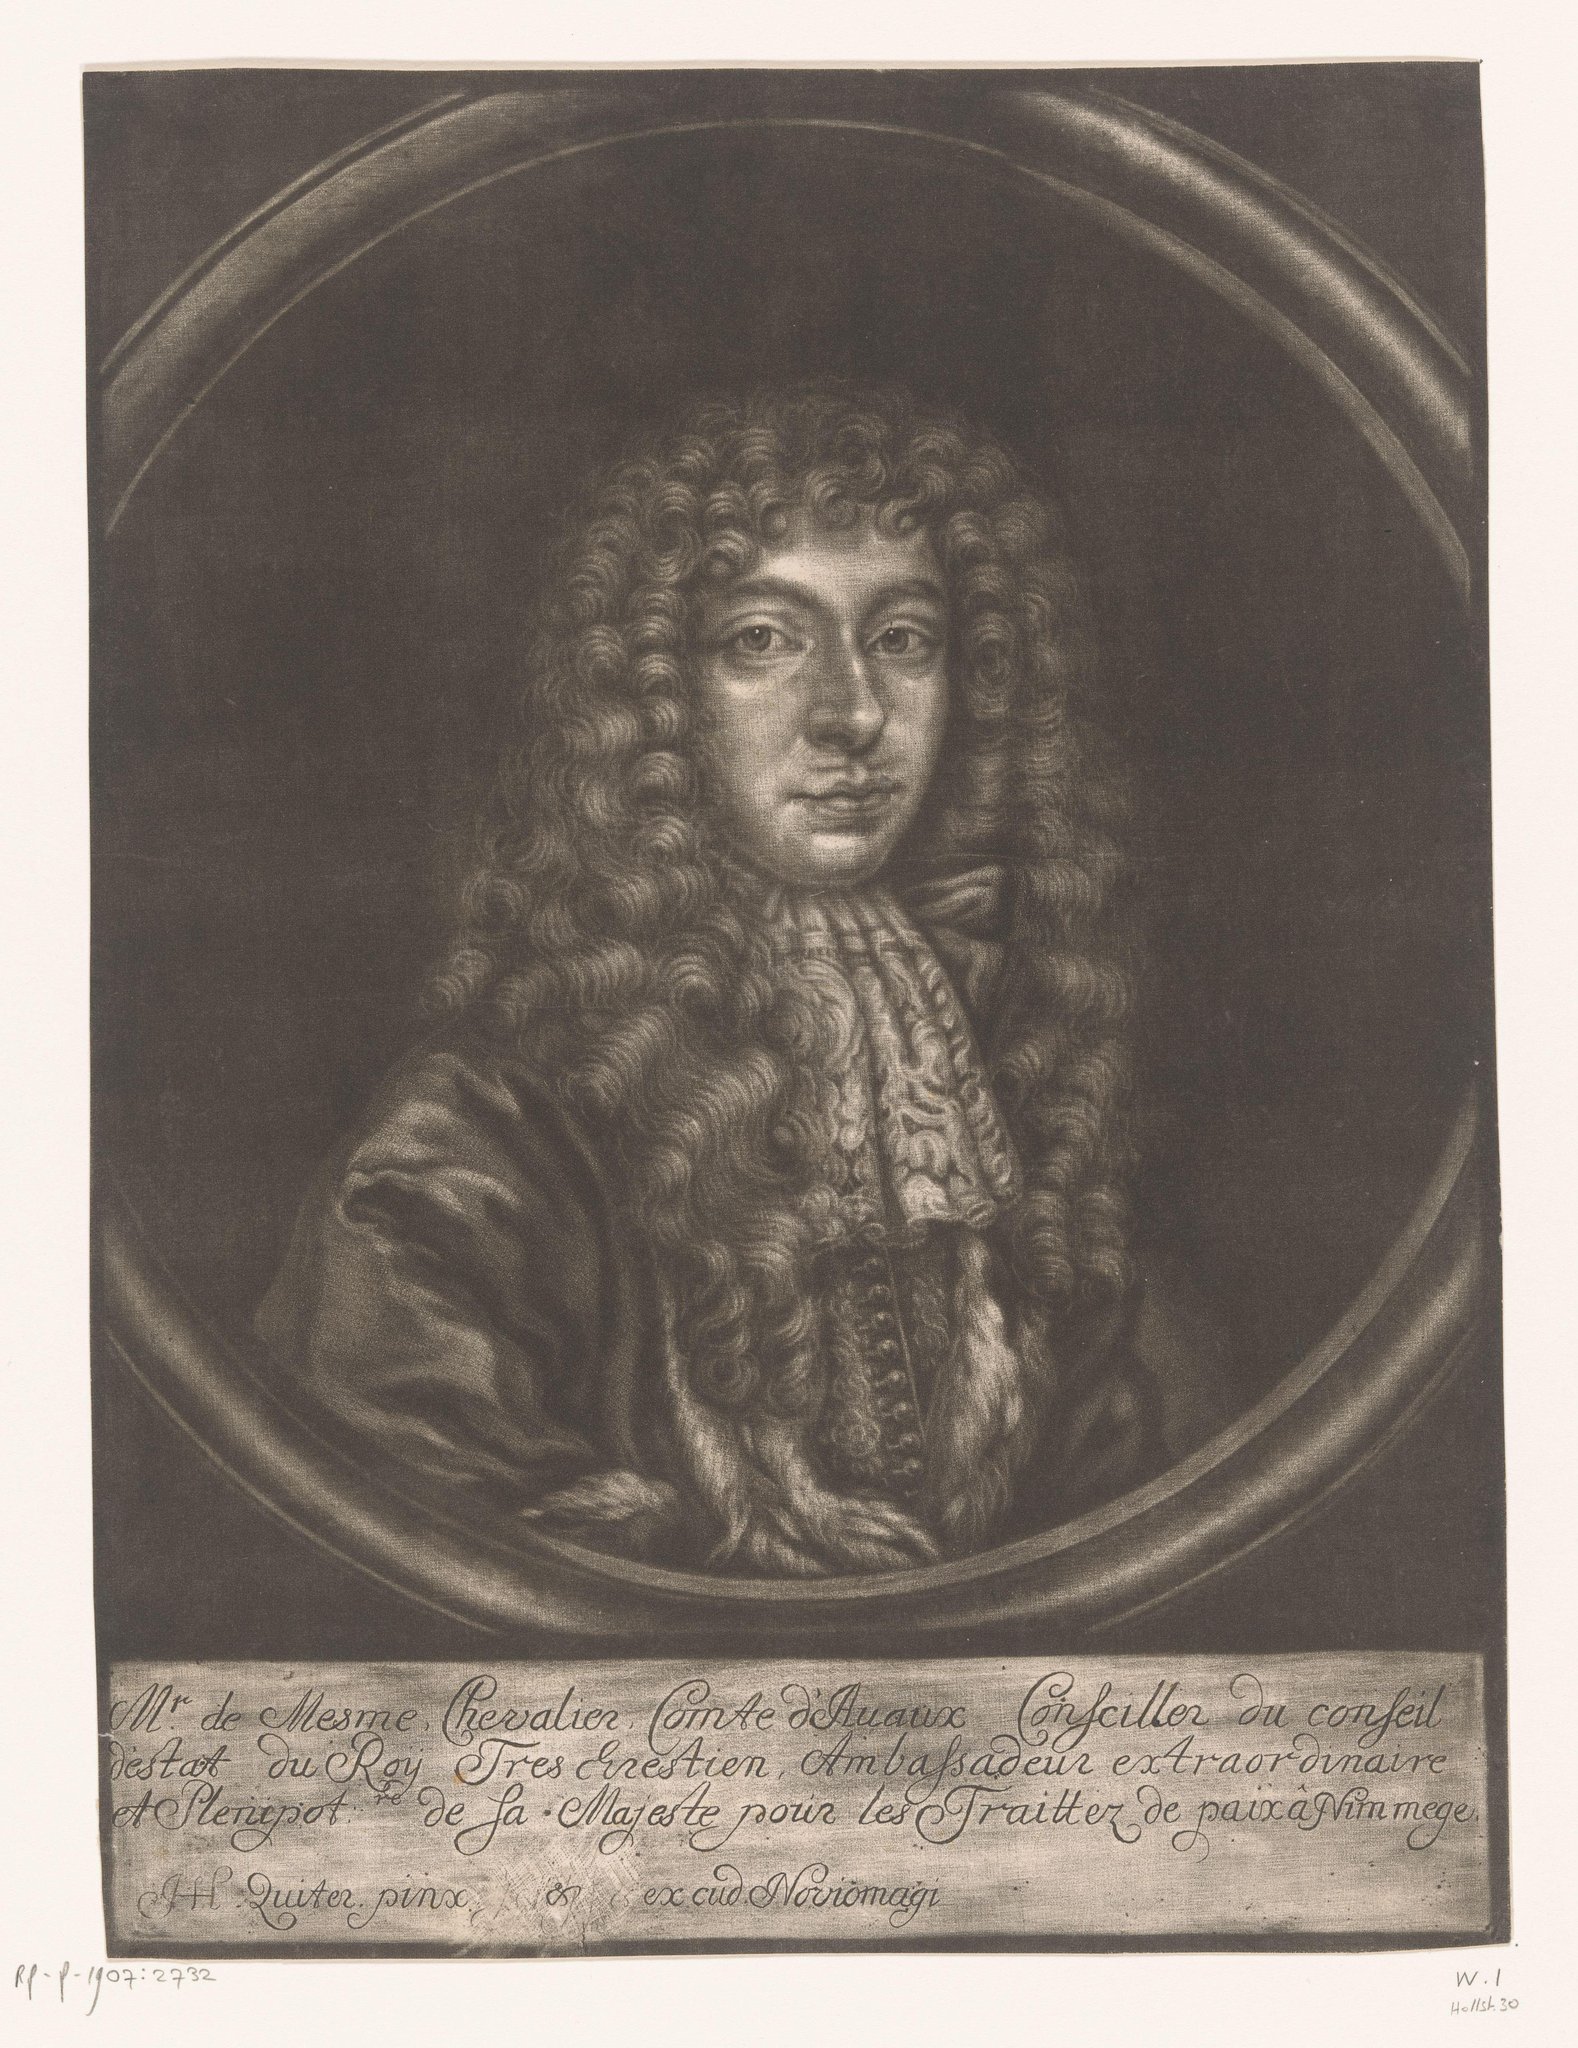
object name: print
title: Portret van Jean-Antoine de Mesmes, comte d'Avaux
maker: herman hendrik de quiter (i)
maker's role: painter, print maker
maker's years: 1627-1708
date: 1679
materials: paper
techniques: mezzotint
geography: nijmegen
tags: historical persons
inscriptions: collector's mark: Lugt 2228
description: Prent voor het eerst gebruikt in: Quiter, Hermann Hendrik. Icones legatorum (...). Nijmegen: s.n., 1679.